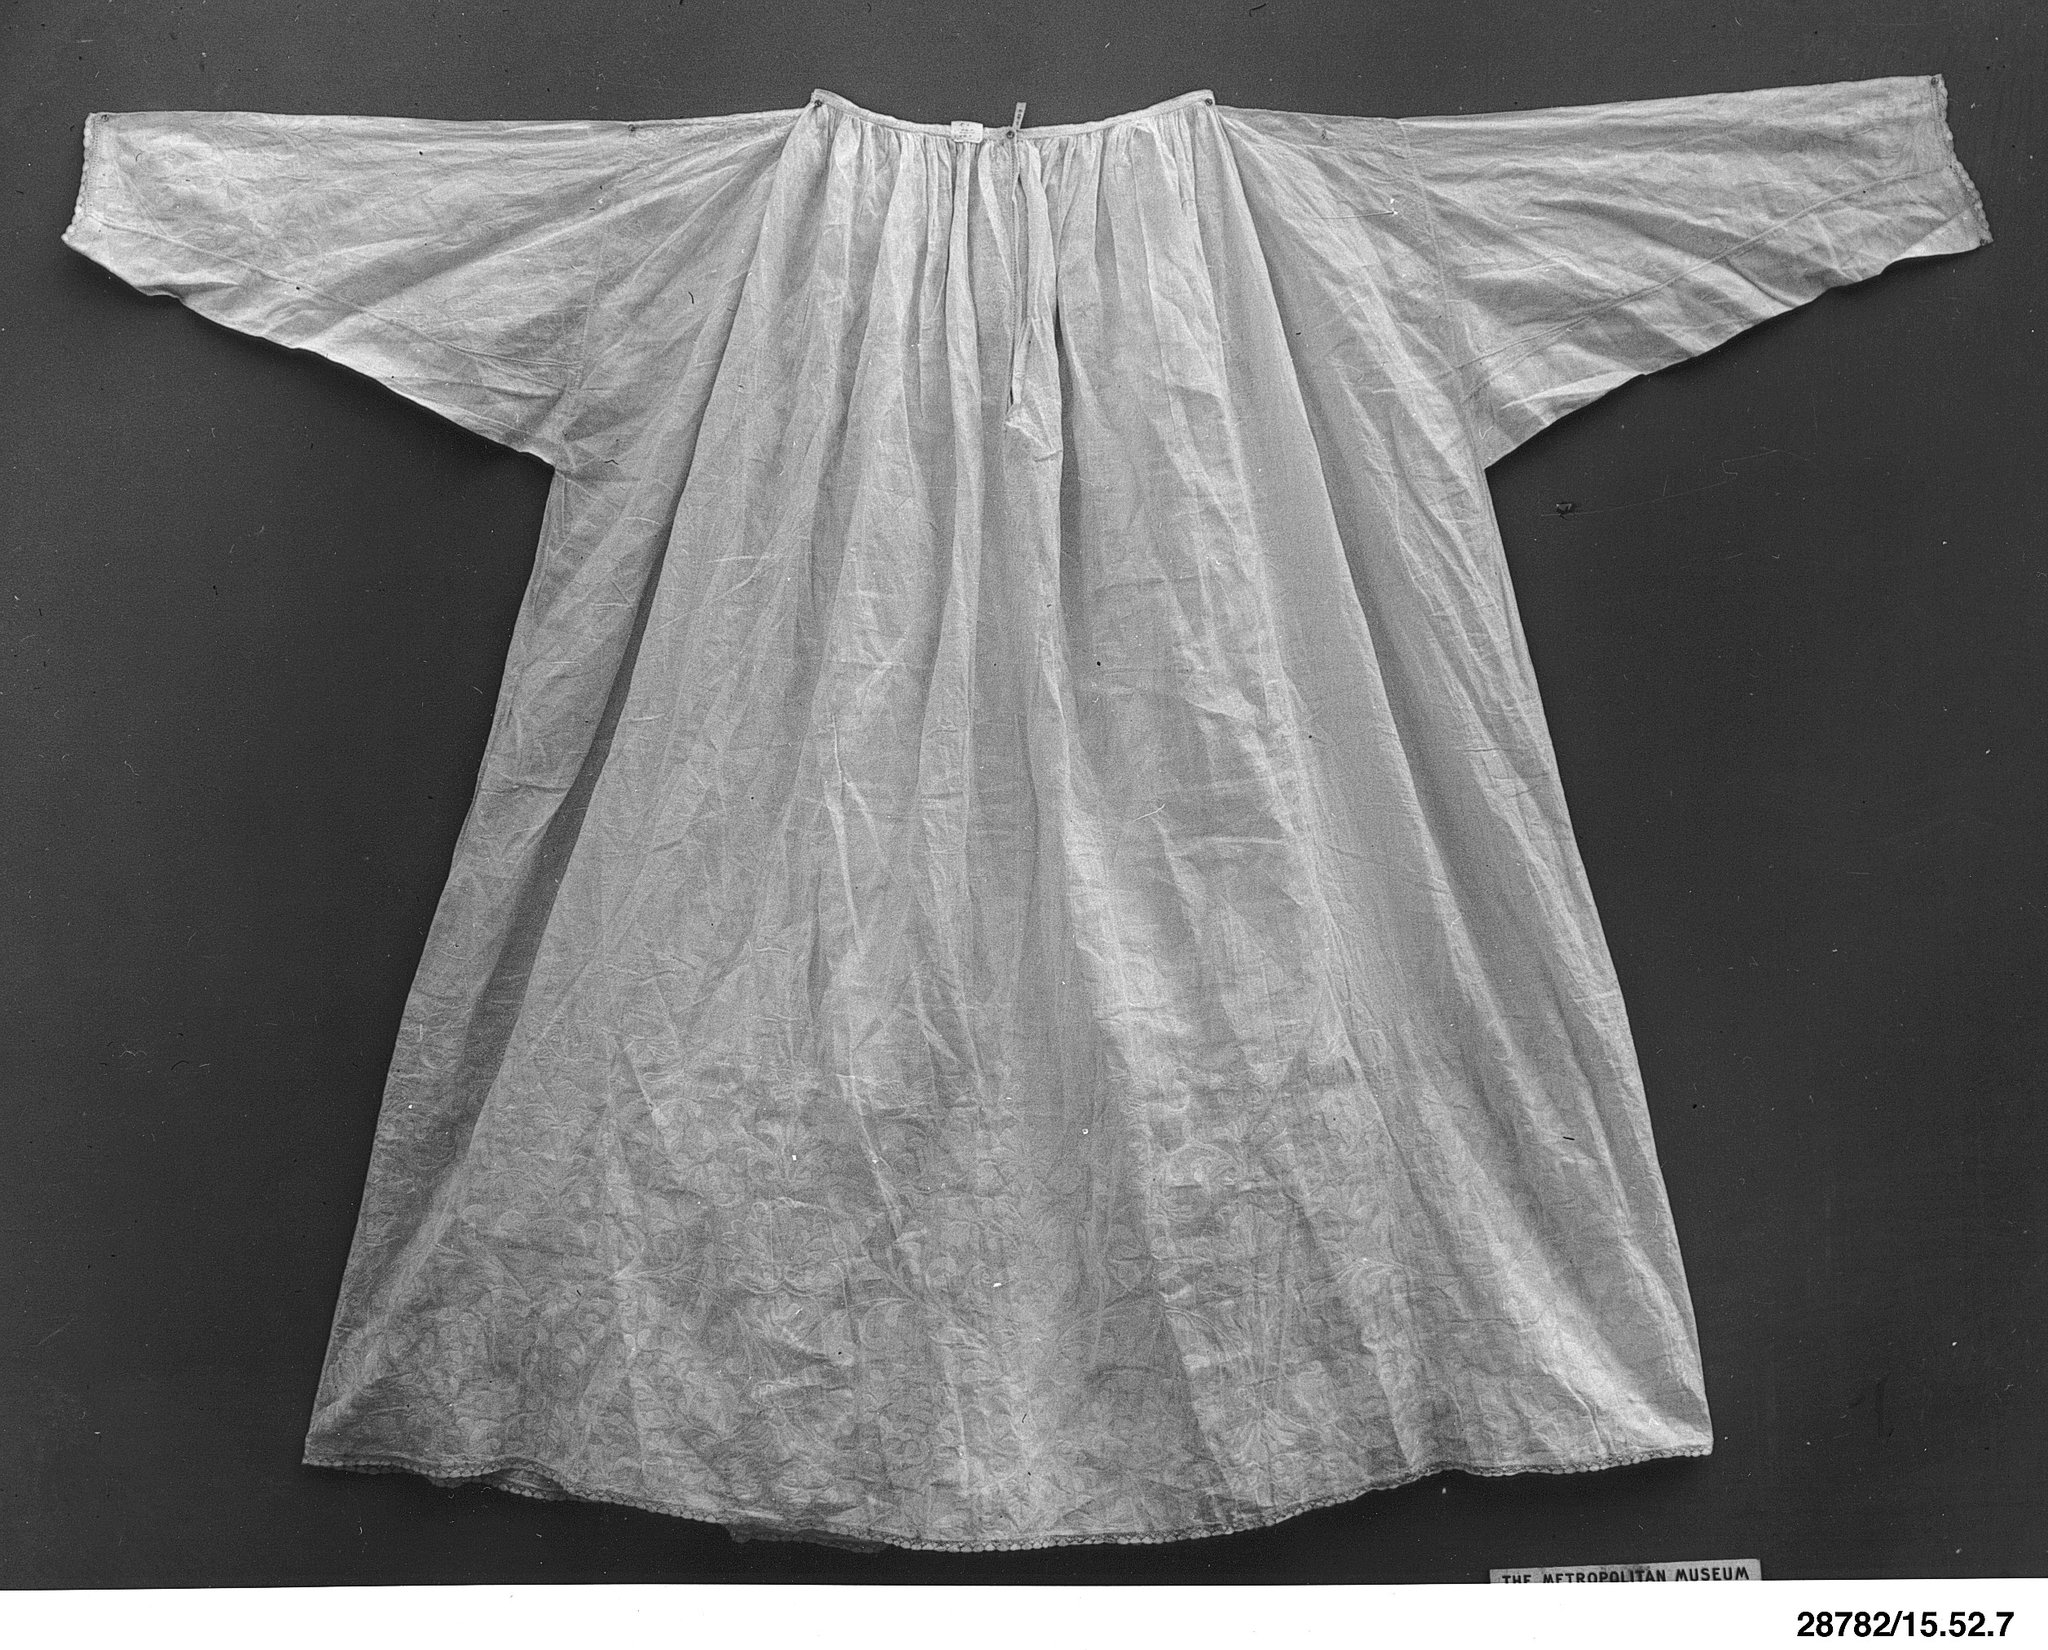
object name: rochet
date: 1701-1800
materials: linen